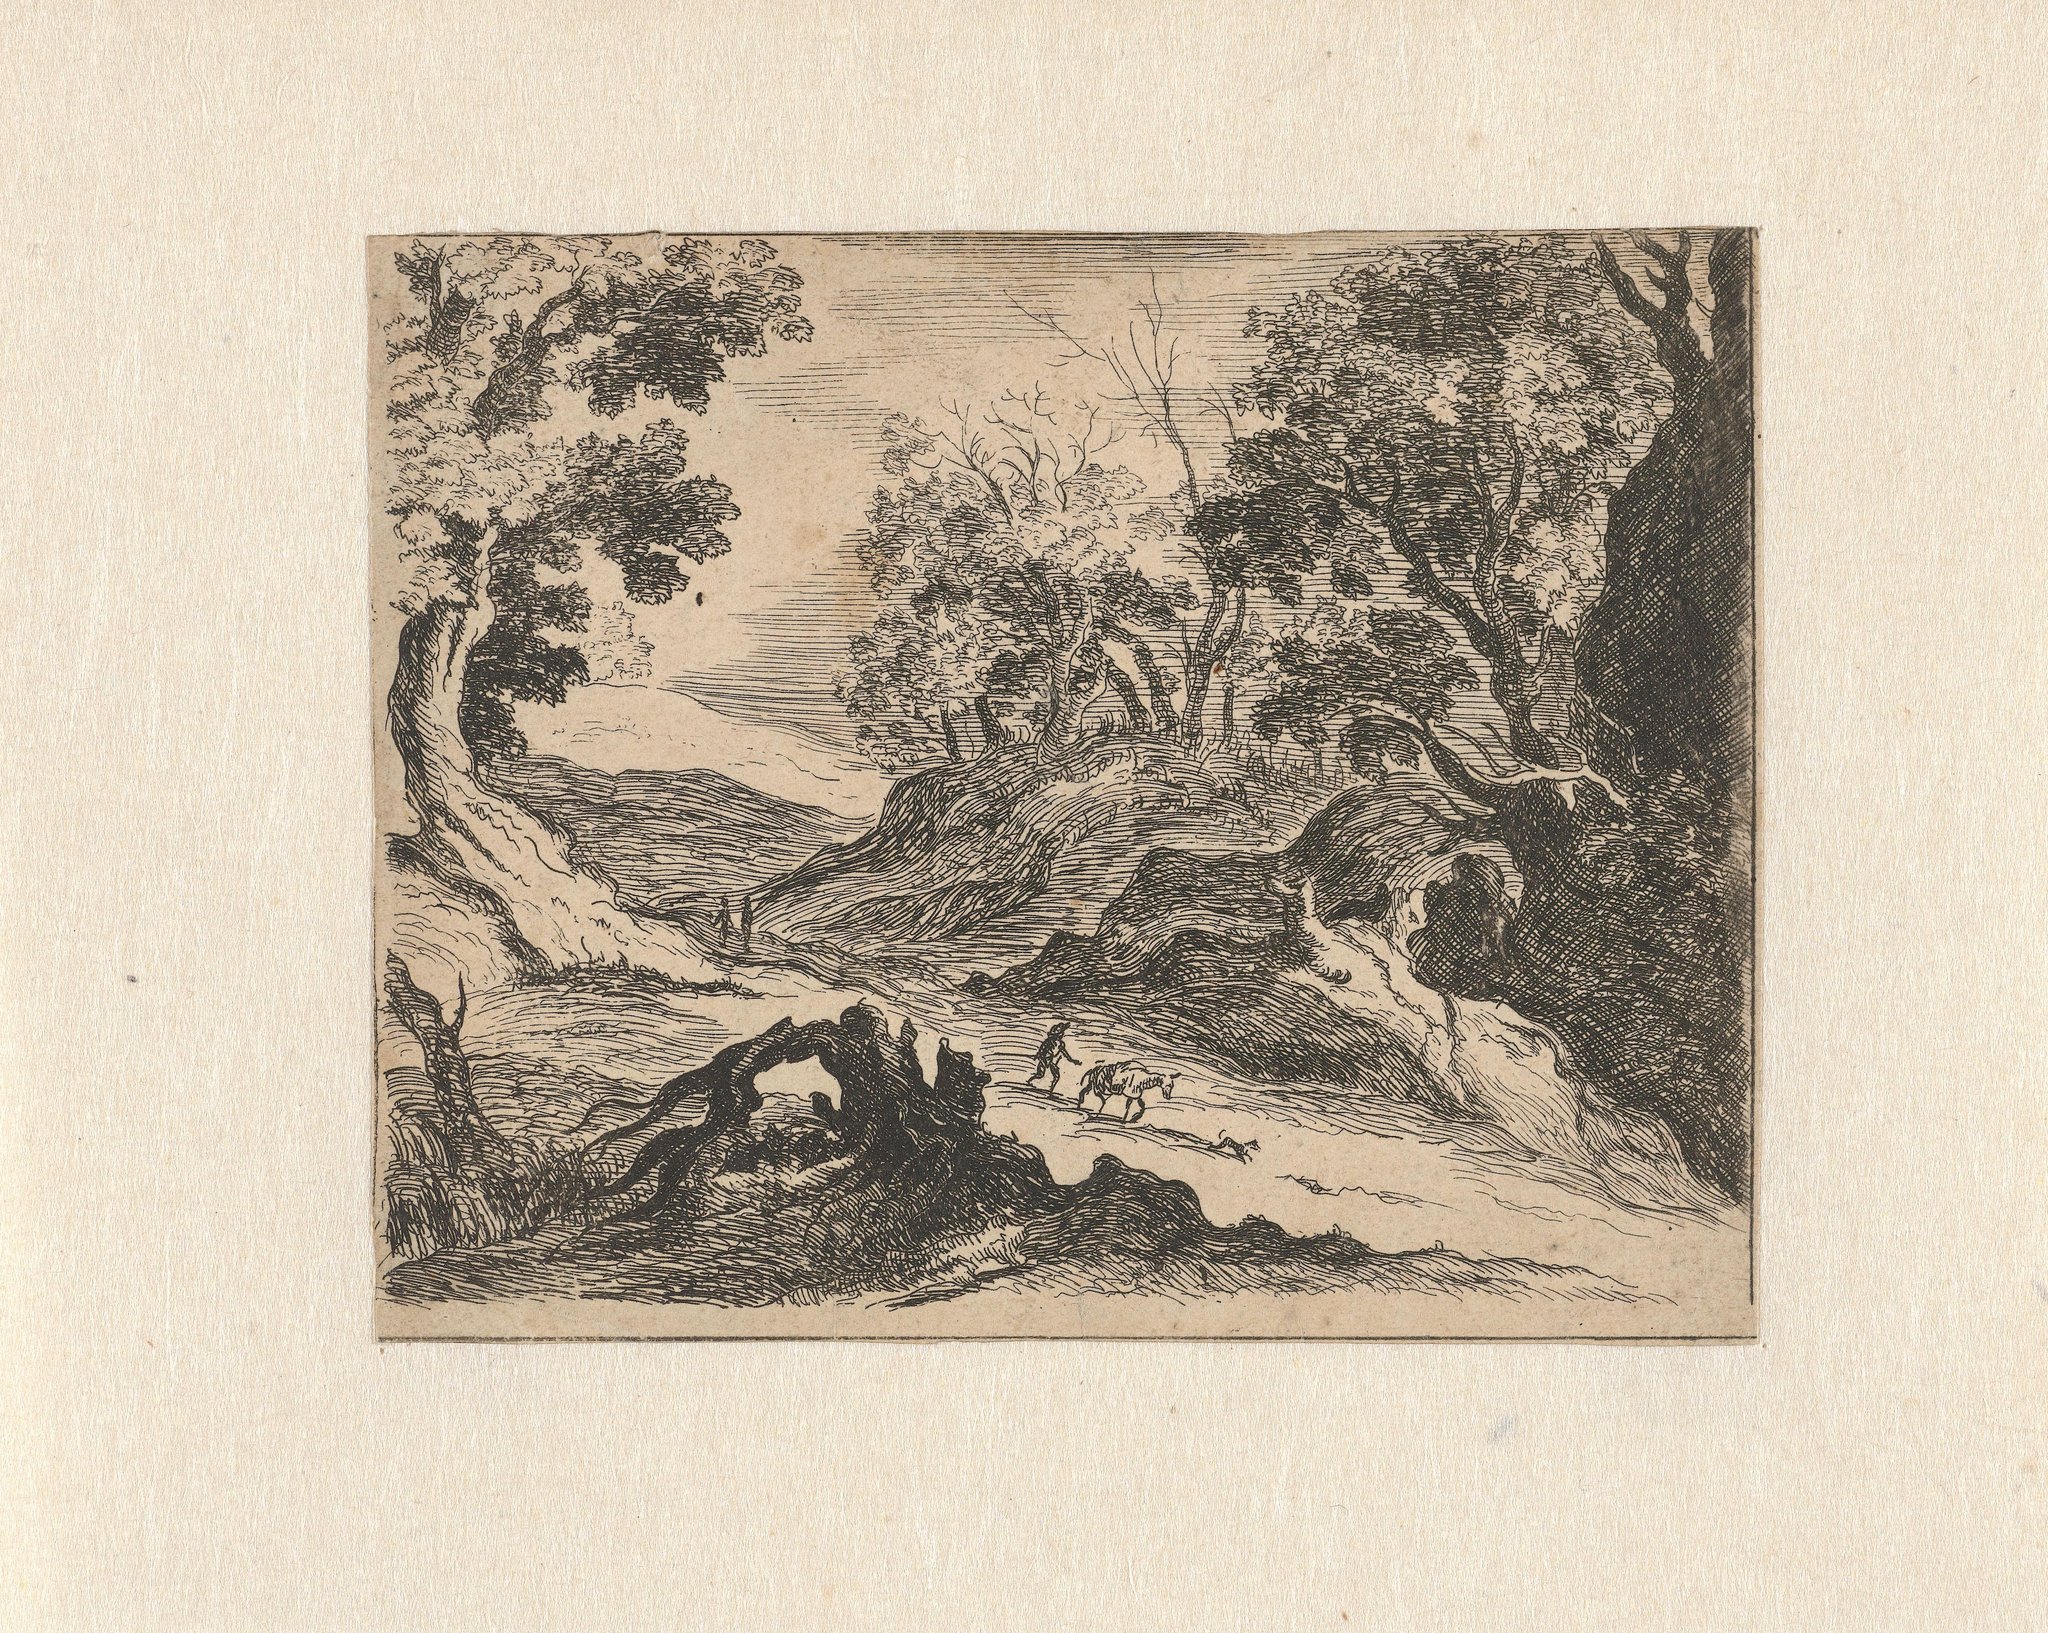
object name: print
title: Heuvellandschap met een ezelhoeder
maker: anna maria de koker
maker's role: print maker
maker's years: -1698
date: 1640-1698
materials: paper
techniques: etching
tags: low hill country, trees, ass, donkey, herding, herdsman, herdswoman, shepherd, shepherdess, cowherd, etc., dog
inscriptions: collector's mark: Lugt 2228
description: Door een heuvelachtig landschap loopt een landweg waarop een man zijn ezel voortdrijft. Voor de man en de ezel huppelt een hondje en links op de voorgrond staat een kale afgebroken boom. Op de achtergrond zijn twee figuren te zien.